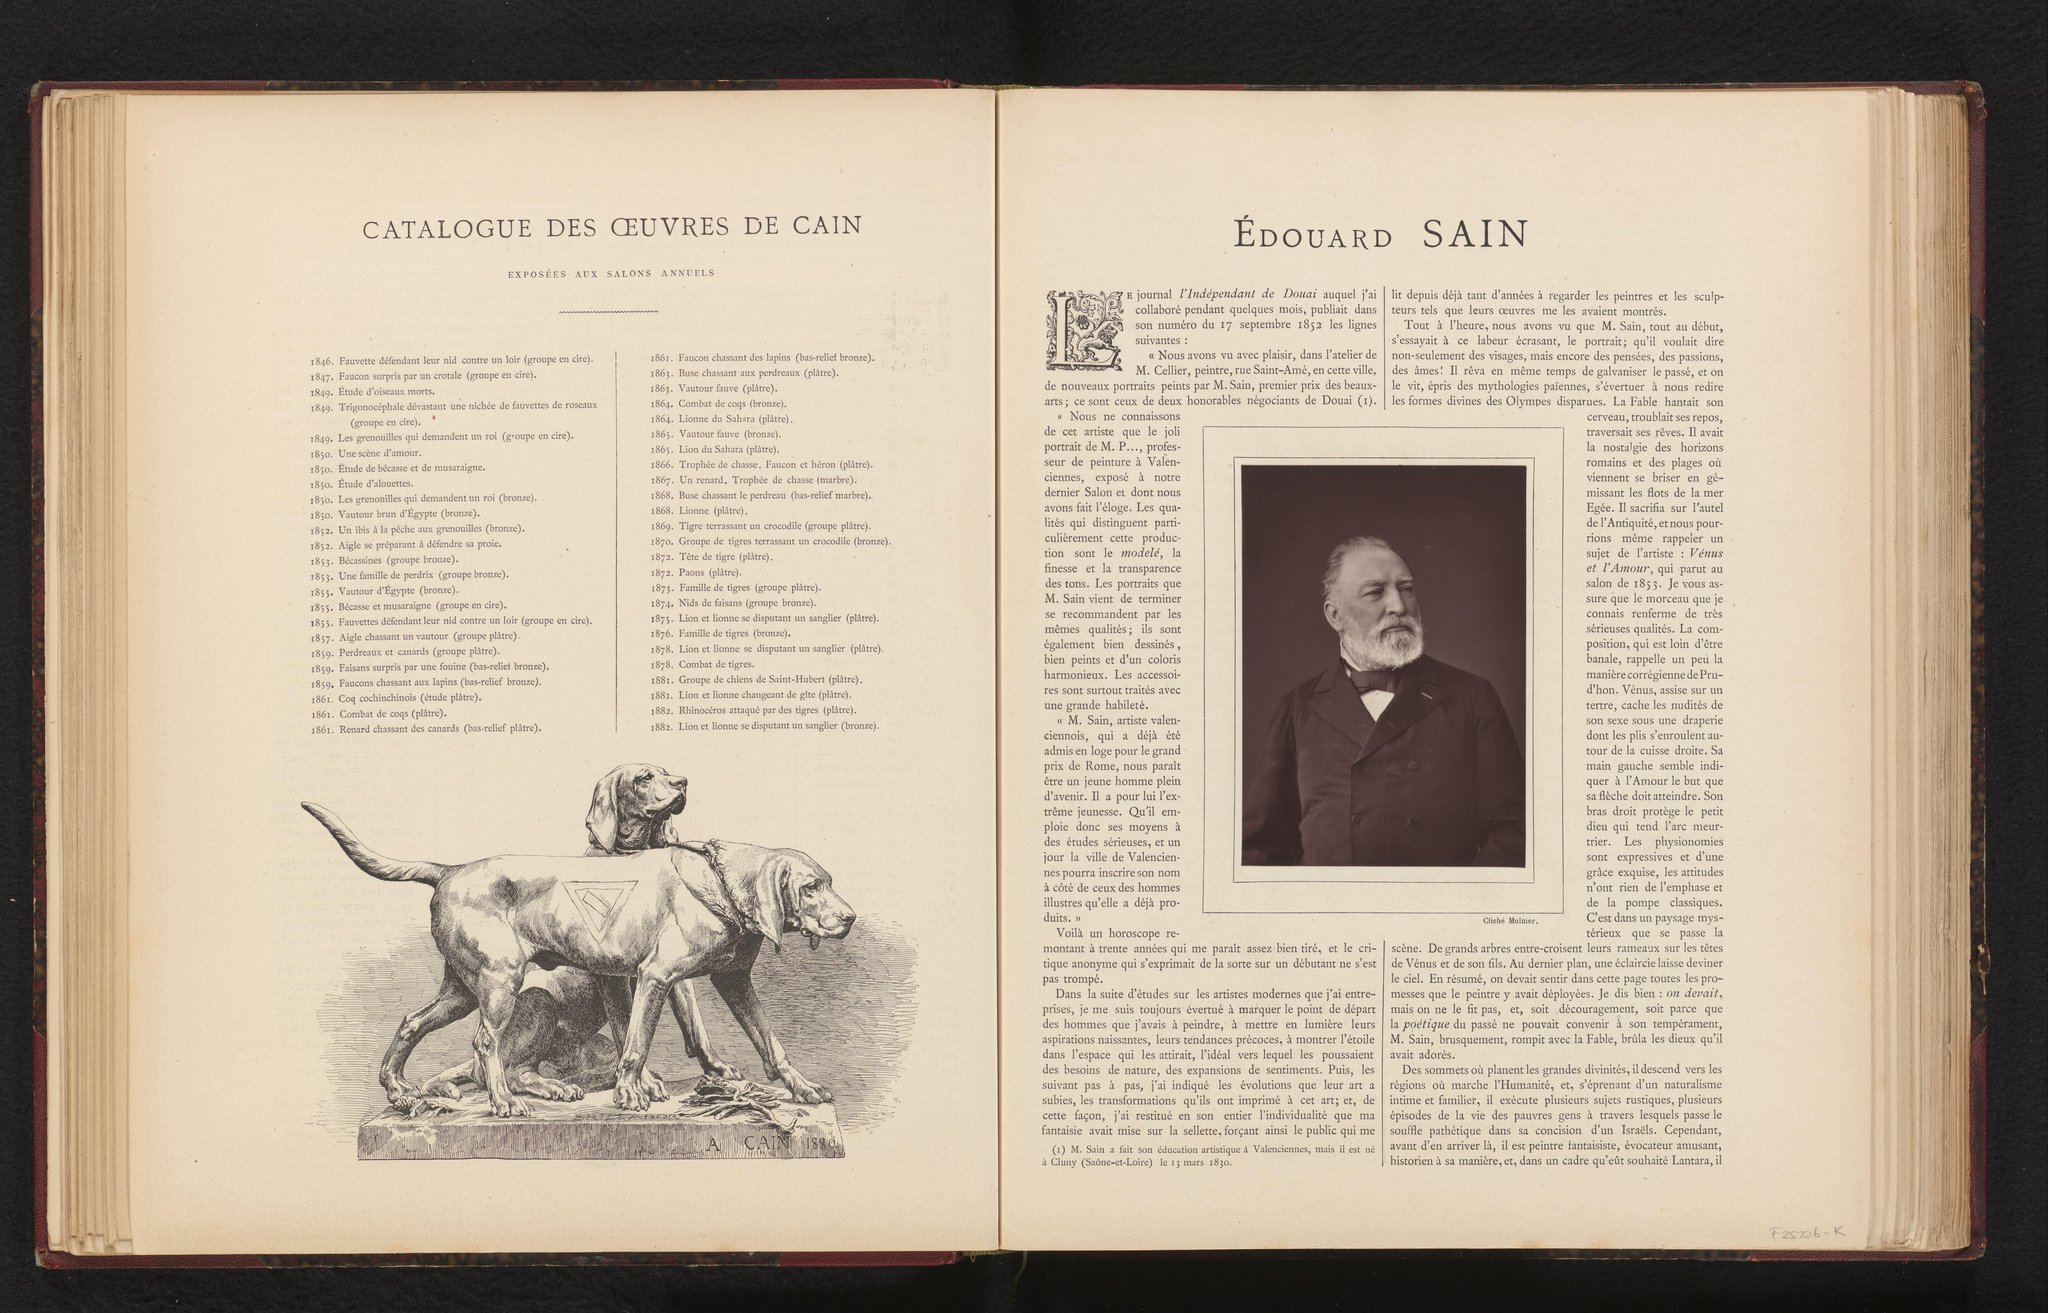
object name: page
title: Édouard Sain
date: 1878-1883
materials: paper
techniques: woodburytype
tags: painter, édouard alexandre sain, historical persons